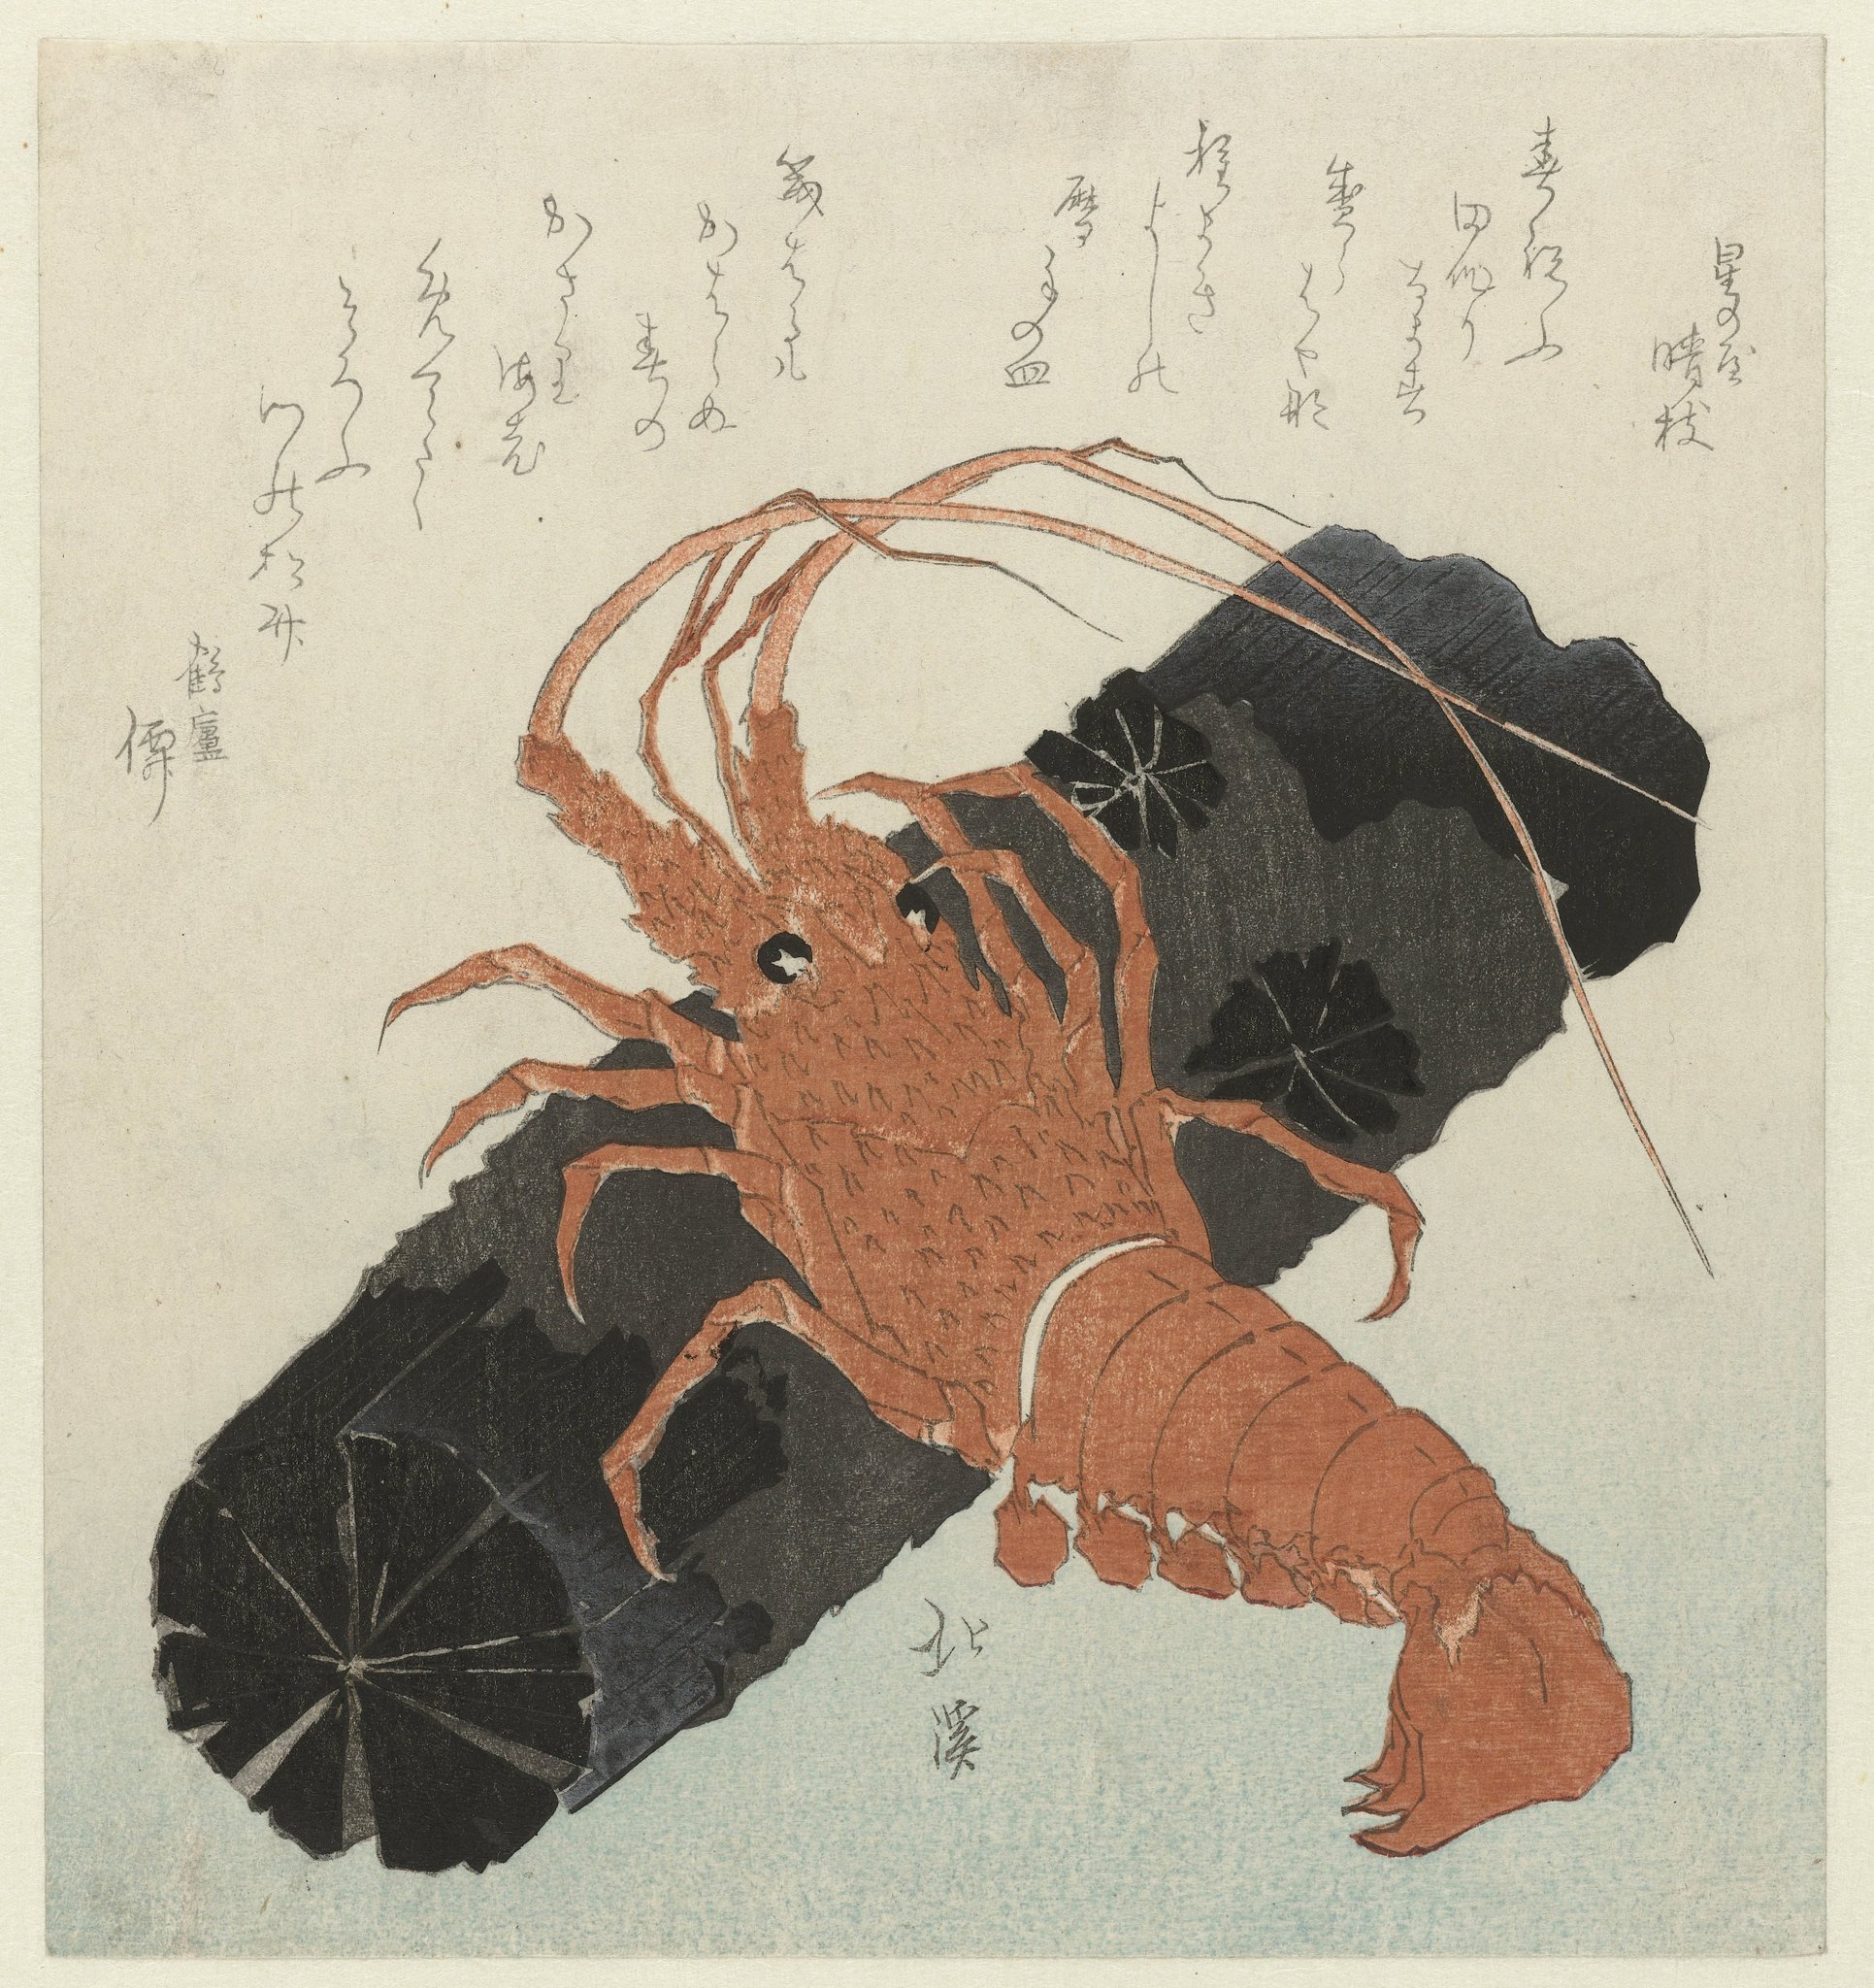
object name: surimono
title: Kreeft met houtskool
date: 1830-1839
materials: paper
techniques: blind stamped, woodcut, polish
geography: japan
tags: crustaceans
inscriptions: collector's mark, passe-partout, bottom left, printed: JABdH with a rooster., collector's mark, verso, stamped: Lugt 2228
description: Een surimono is een luxe uitgevoerde prent waarop beeld met één of meerdere gedichten gecombineerd is. Bij het drukken van een surimono werd vaak gebruik gemaakt van dikker papier, blinddruk en metaal pigmenten, zoals koper- en zilverpoeder. De prenten werden vaak in opdracht van dichters gemaakt en als exclusief geschenk aan vrienden en relaties gegeven.